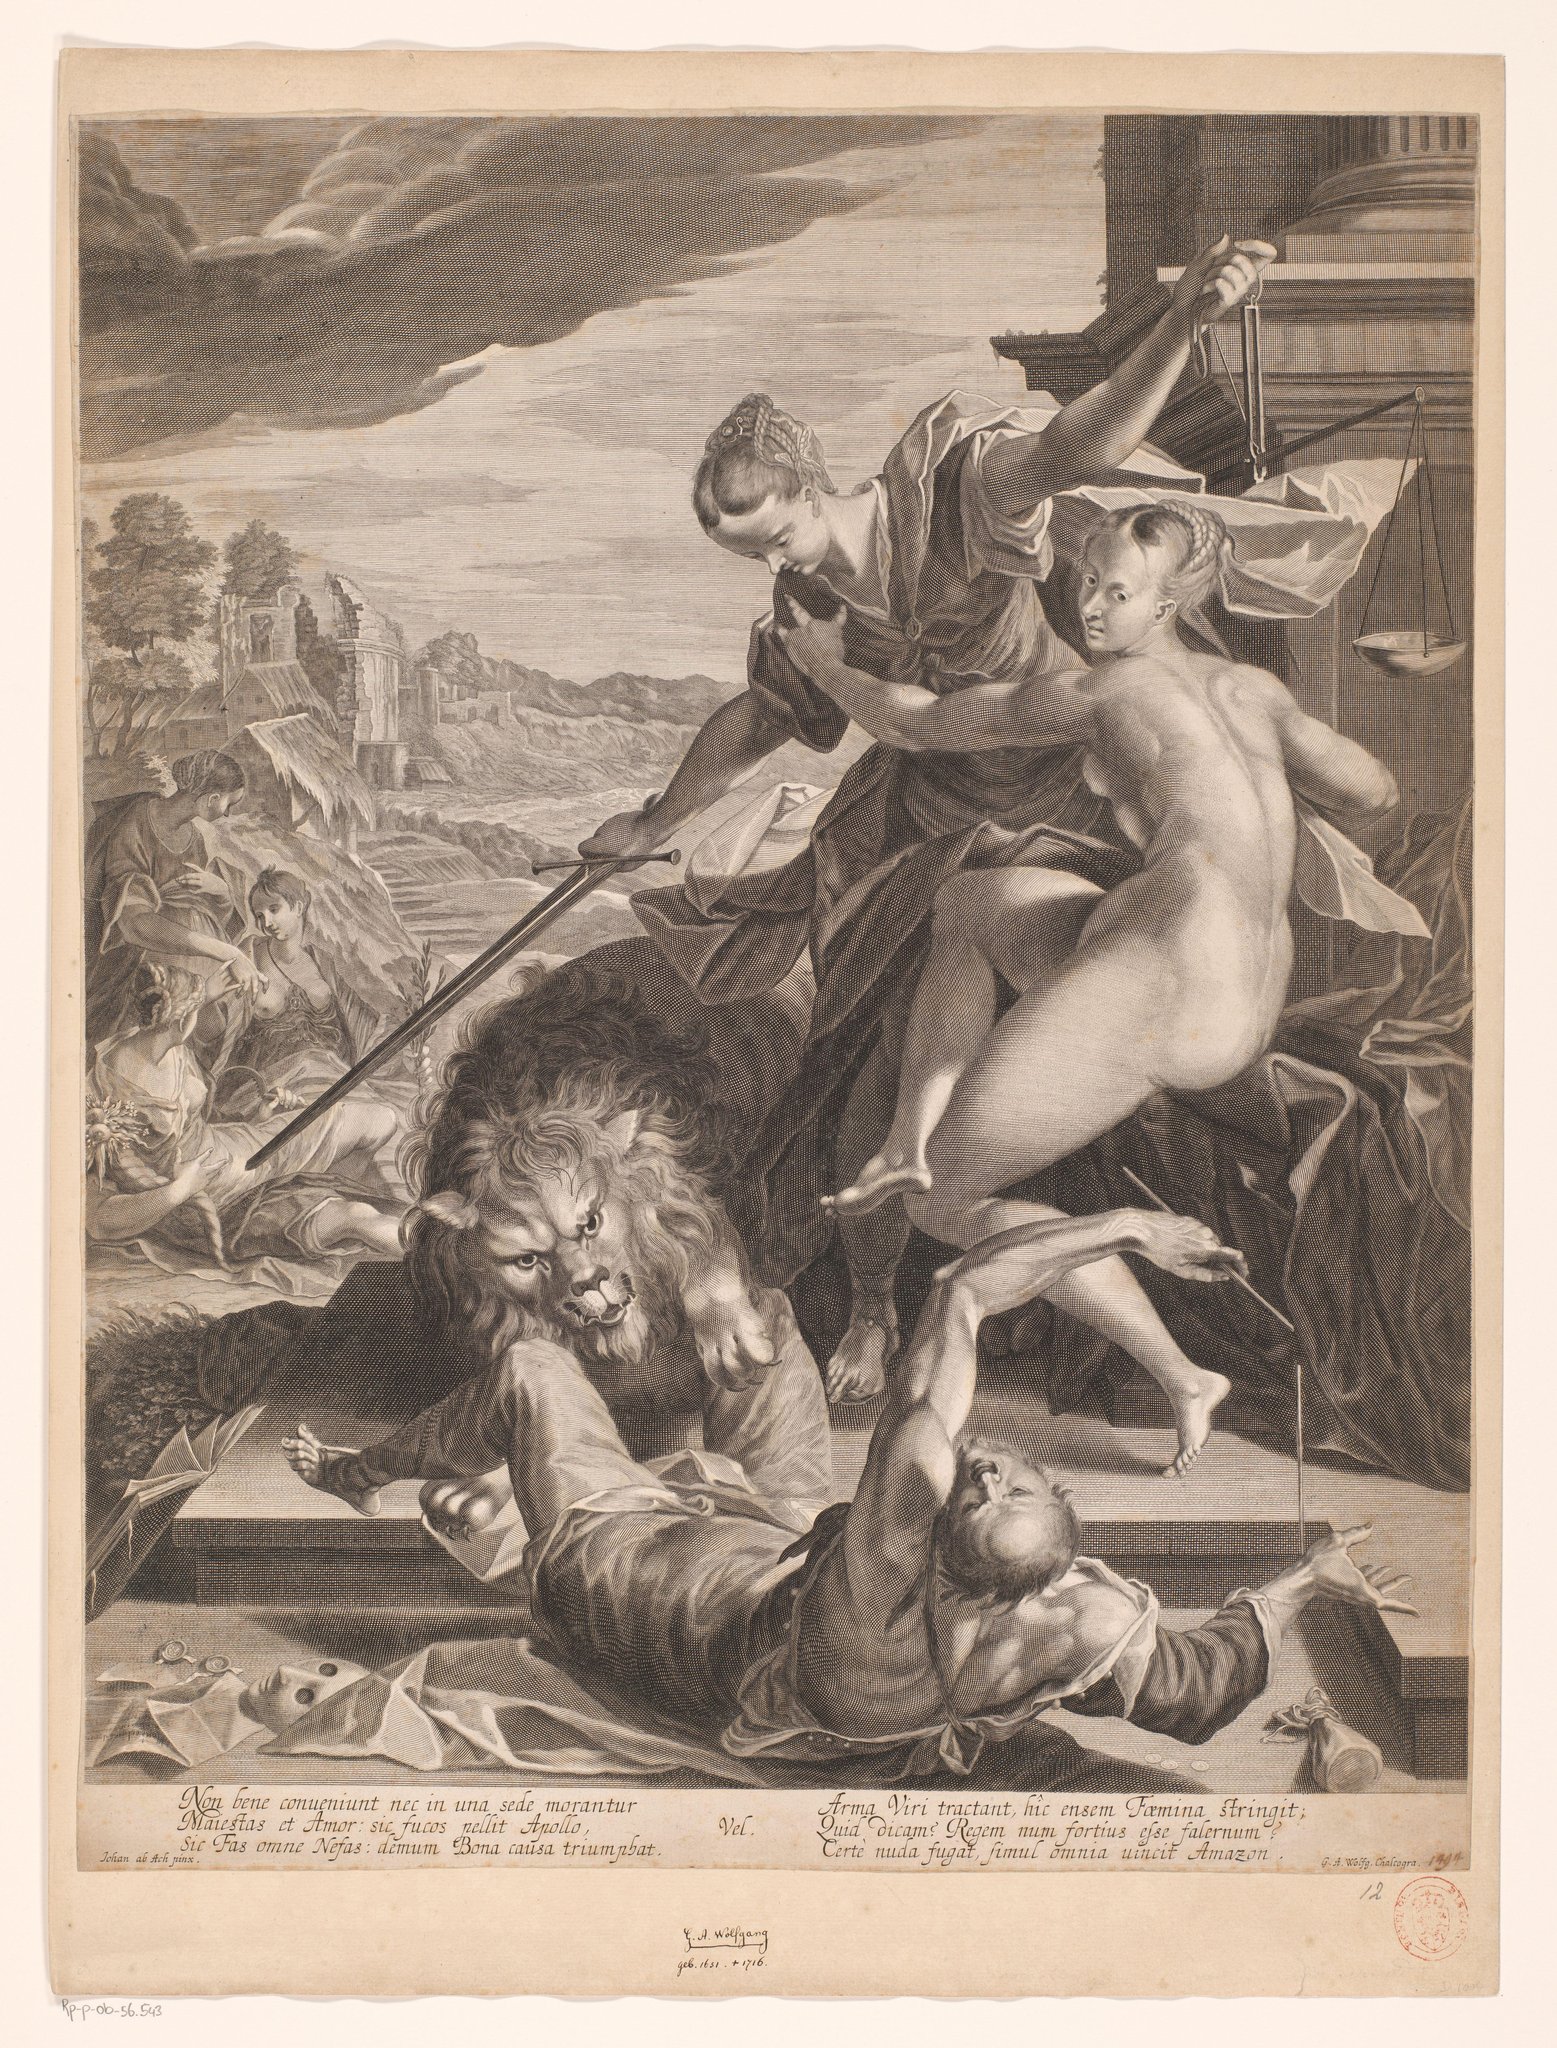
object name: print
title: Allegorie op de triomf van Gerechtigheid en Waarheid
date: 1641-1716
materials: paper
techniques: engraving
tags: mask, justice, 'justitia'; 'giustitia divina' (ripa) ~ one of the four cardinal virtues, truth; 'verità' (ripa), cheat, deceit; 'fraude', 'inganno' (ripa), beasts of prey, predatory animals: lion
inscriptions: collector's mark: Lugt 240